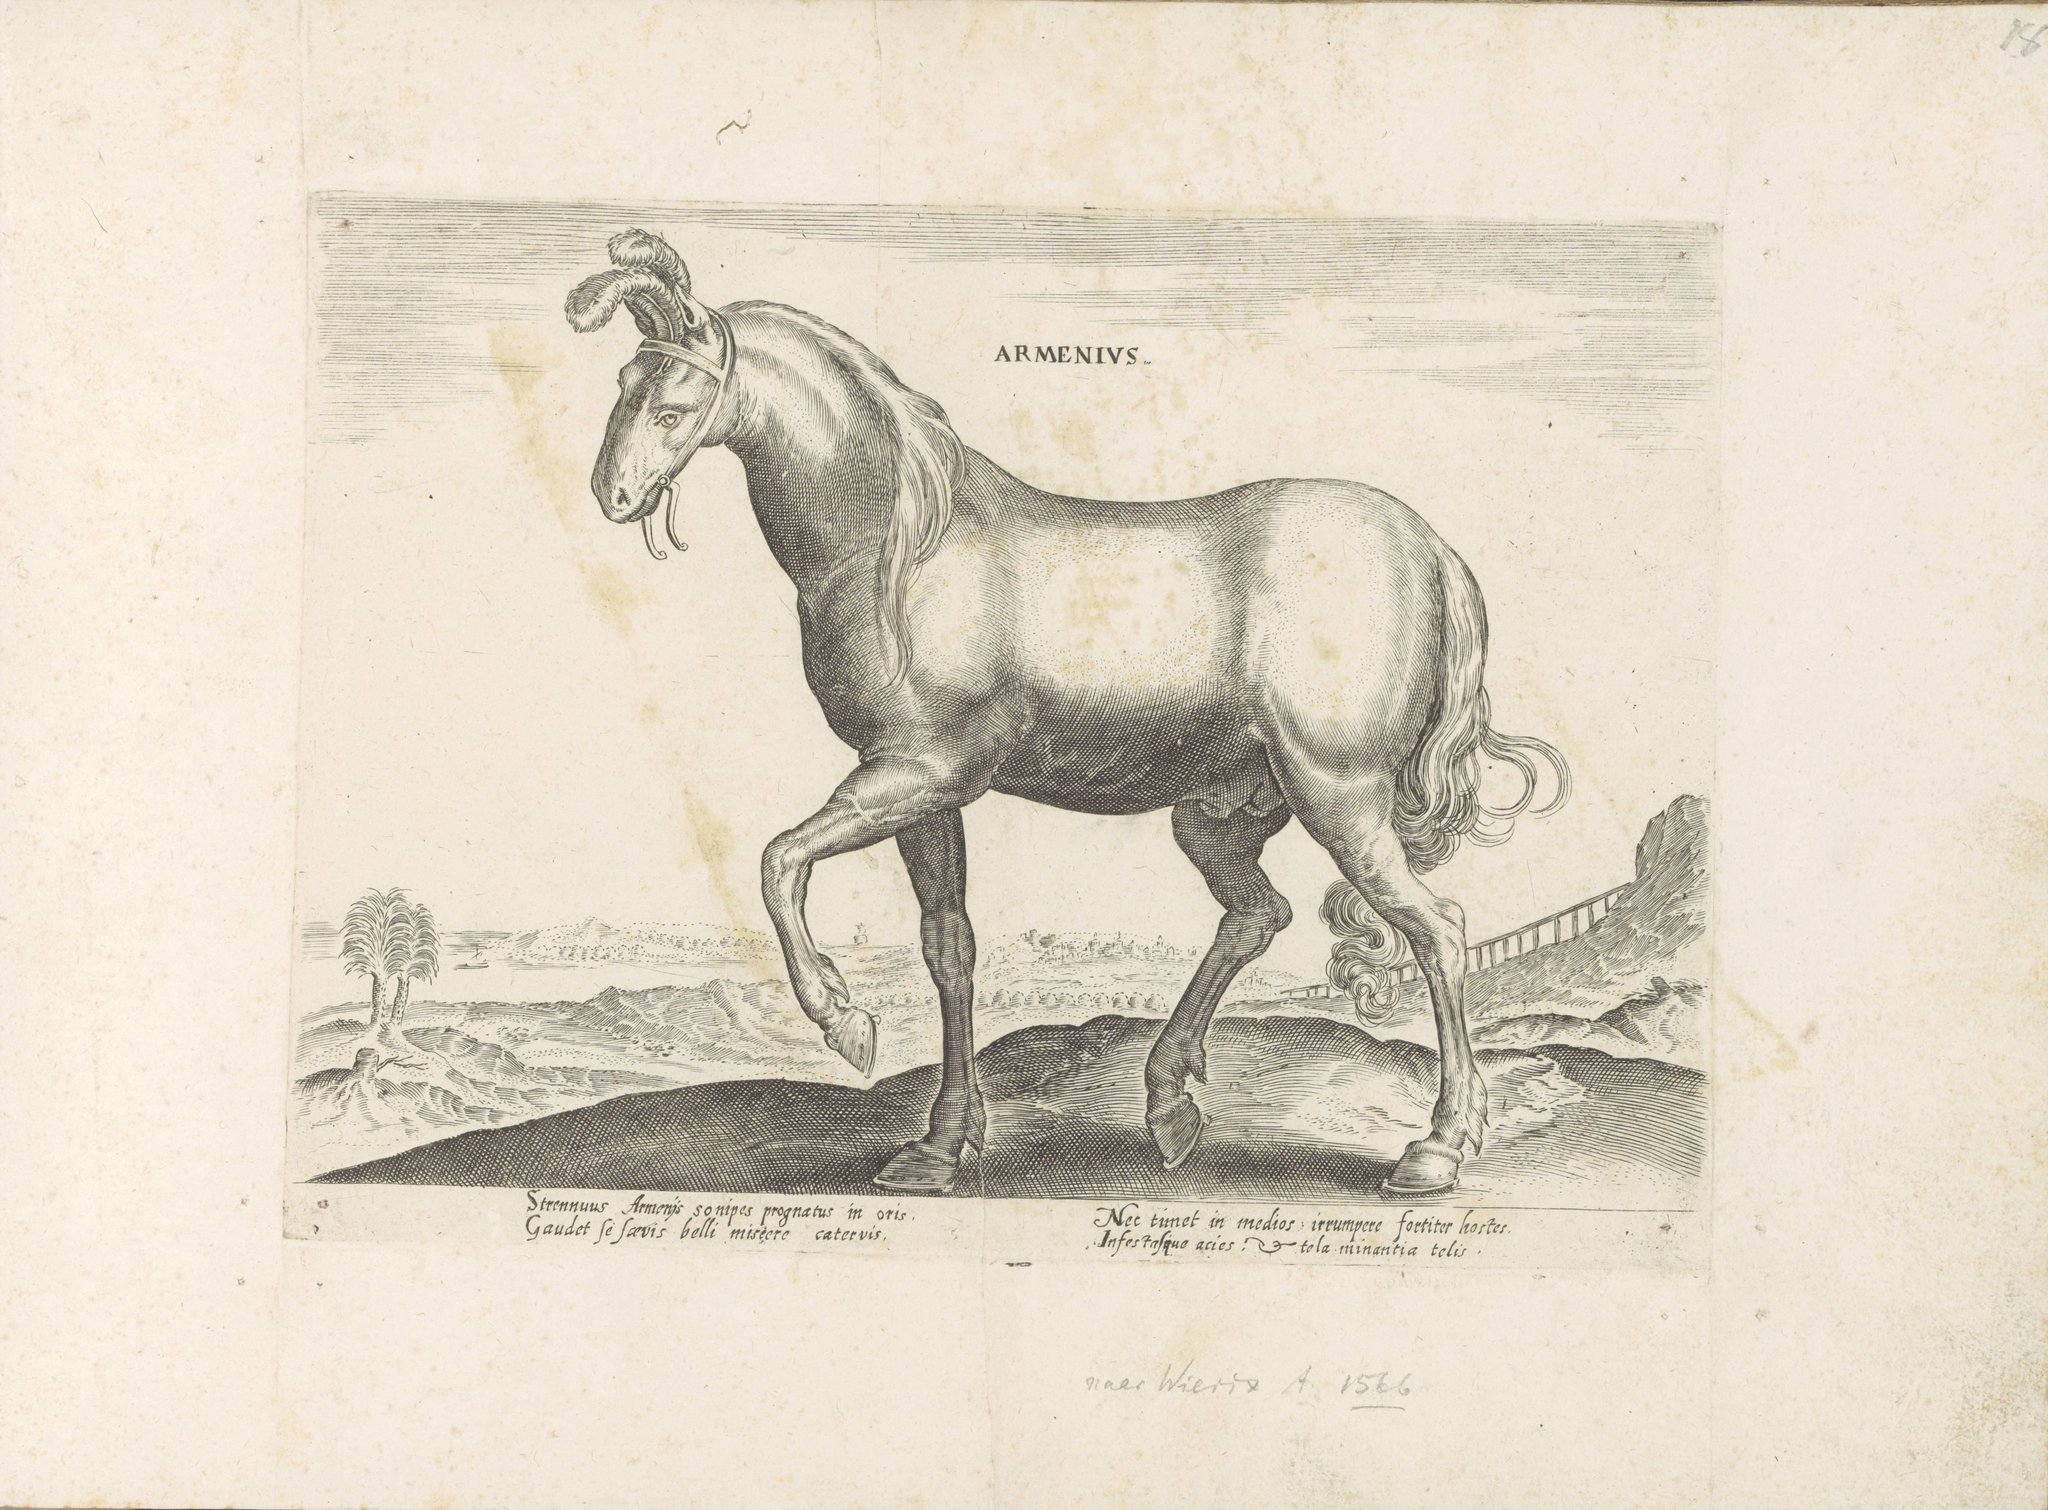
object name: print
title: Paardenrassen uit de Koninklijke stallen van Don Juan van Oostenrijk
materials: paper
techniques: engraving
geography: venice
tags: don juan van oostenrijk, horses and kindred animals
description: Een Armeens paard in een landschap. Prent maakt deel uit van een album.